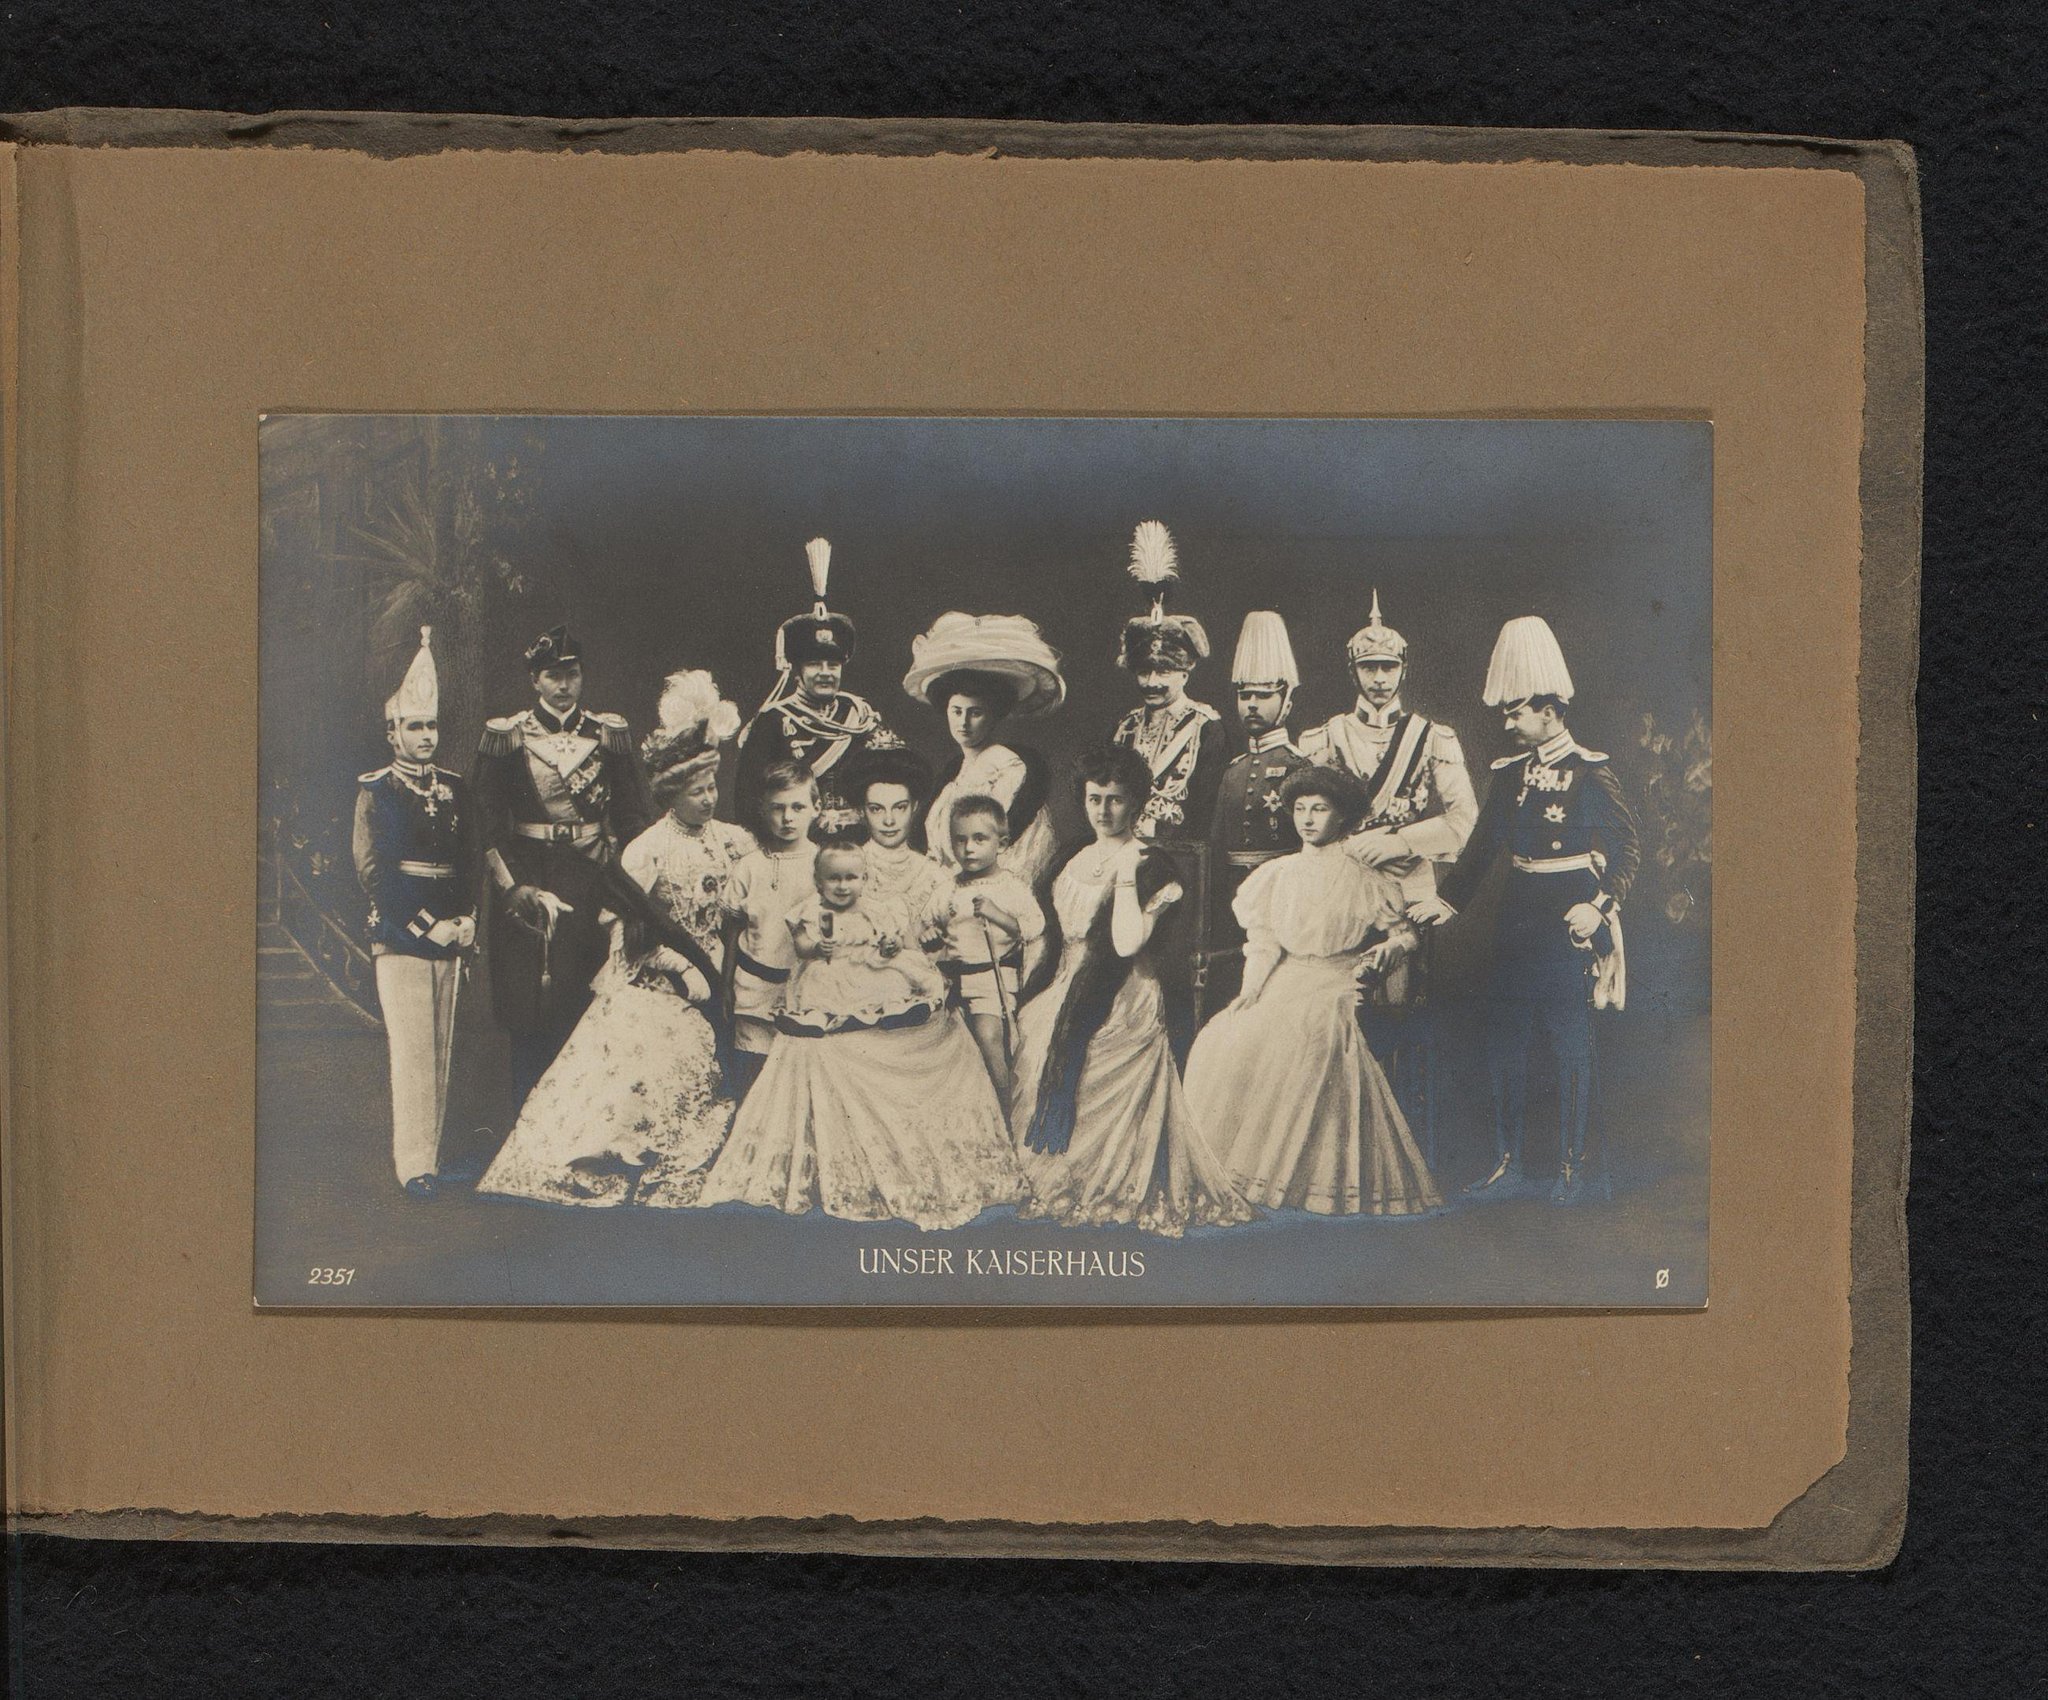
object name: album leaf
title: Fotomontage van een groepsportret van de Duitse keizerlijke familie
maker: Anonymous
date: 1917-1930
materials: paper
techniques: gelatin silver print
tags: lyon, wilhelm ii (keizer van duitsland), augusta victoria (keizerin van duitsland), queen, empress, etc. (wife of a ruler), emperor, princess, king, feudal lord, anonymous historical persons portrayed in a group, in a group-portrait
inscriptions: number: ‘2351’